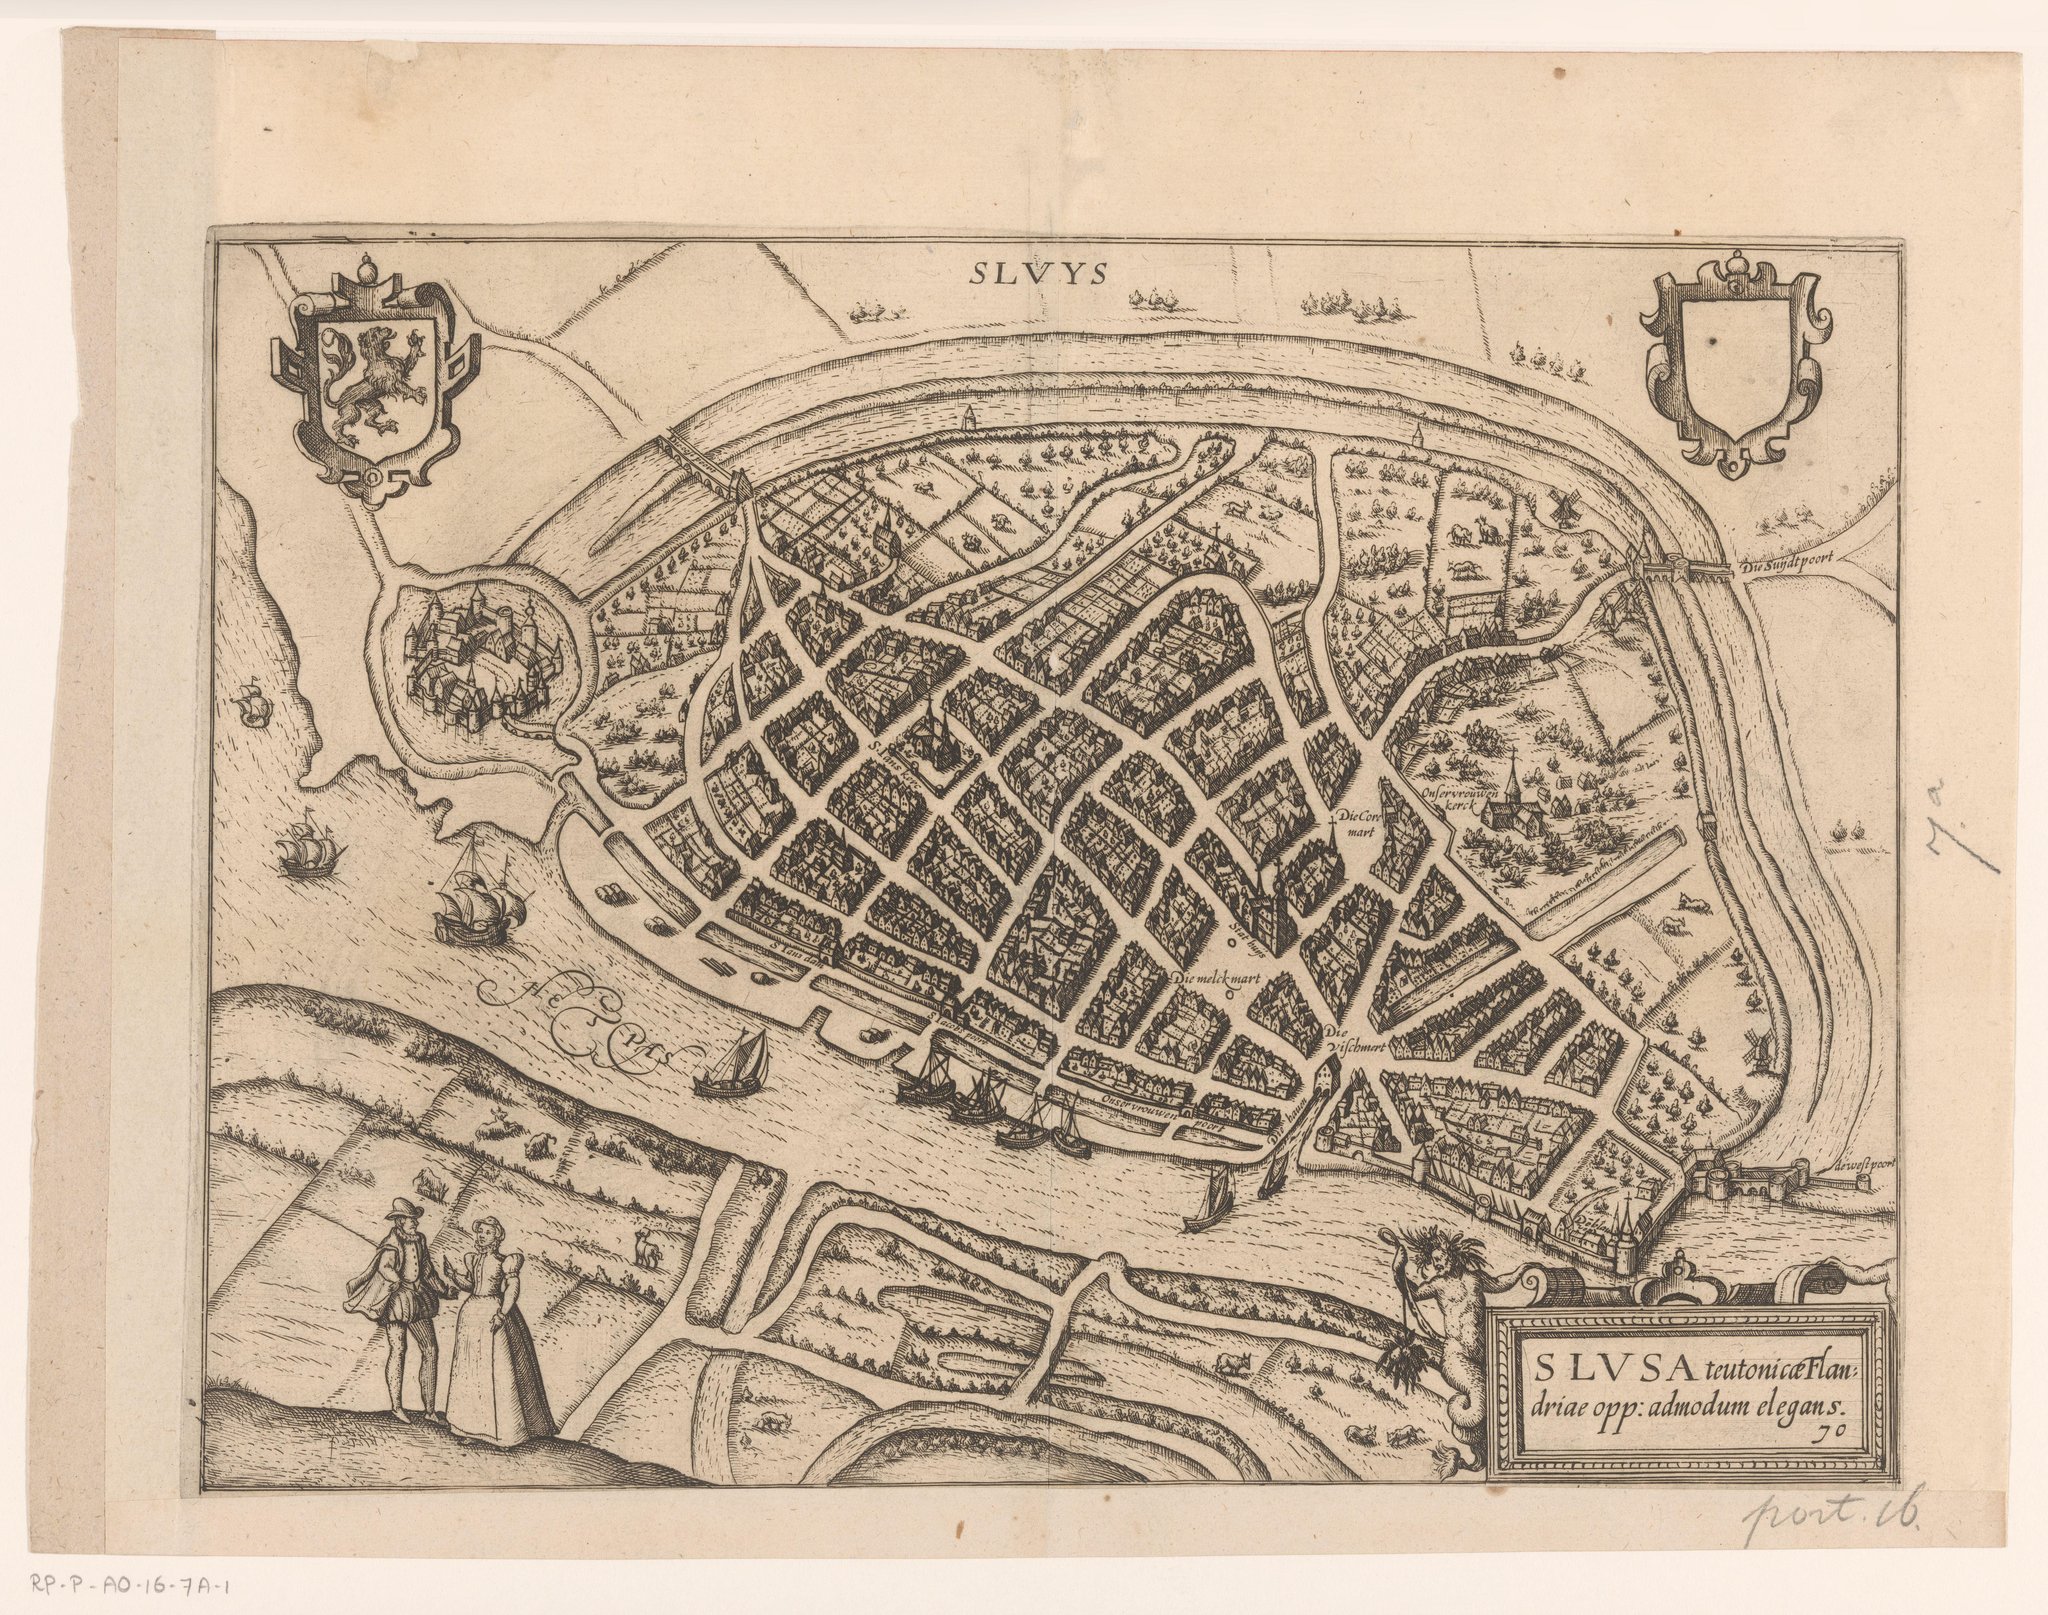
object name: print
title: Sluys / Slusa teutonicae Flandriae opp: admodum elegans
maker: Anonymous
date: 1612-1648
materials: paper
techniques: engraving, etching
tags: coat of arms (as symbol of the state, etc.) (+ city; municipal), maps of cities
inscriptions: collector's mark: Lugt 2228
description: Deze staat van prent voor het eerst ook gebruikt in: Guicciardini, Lodovico. Beschryvinghe van alle de Neder-landen, anderssins ghenoemt Neder-Duytslandt (…). Amsterdam: Willem Janszoon Blaeu, 1612. Hierna is deze prent tot 1648 nog gebruikt in latere uitgaven van deze publicatie, uitgegeven door Blaeu en daarna door Janssonius. Uit welke uitgave het huidige exemplaar precies komt is niet na te gaan.